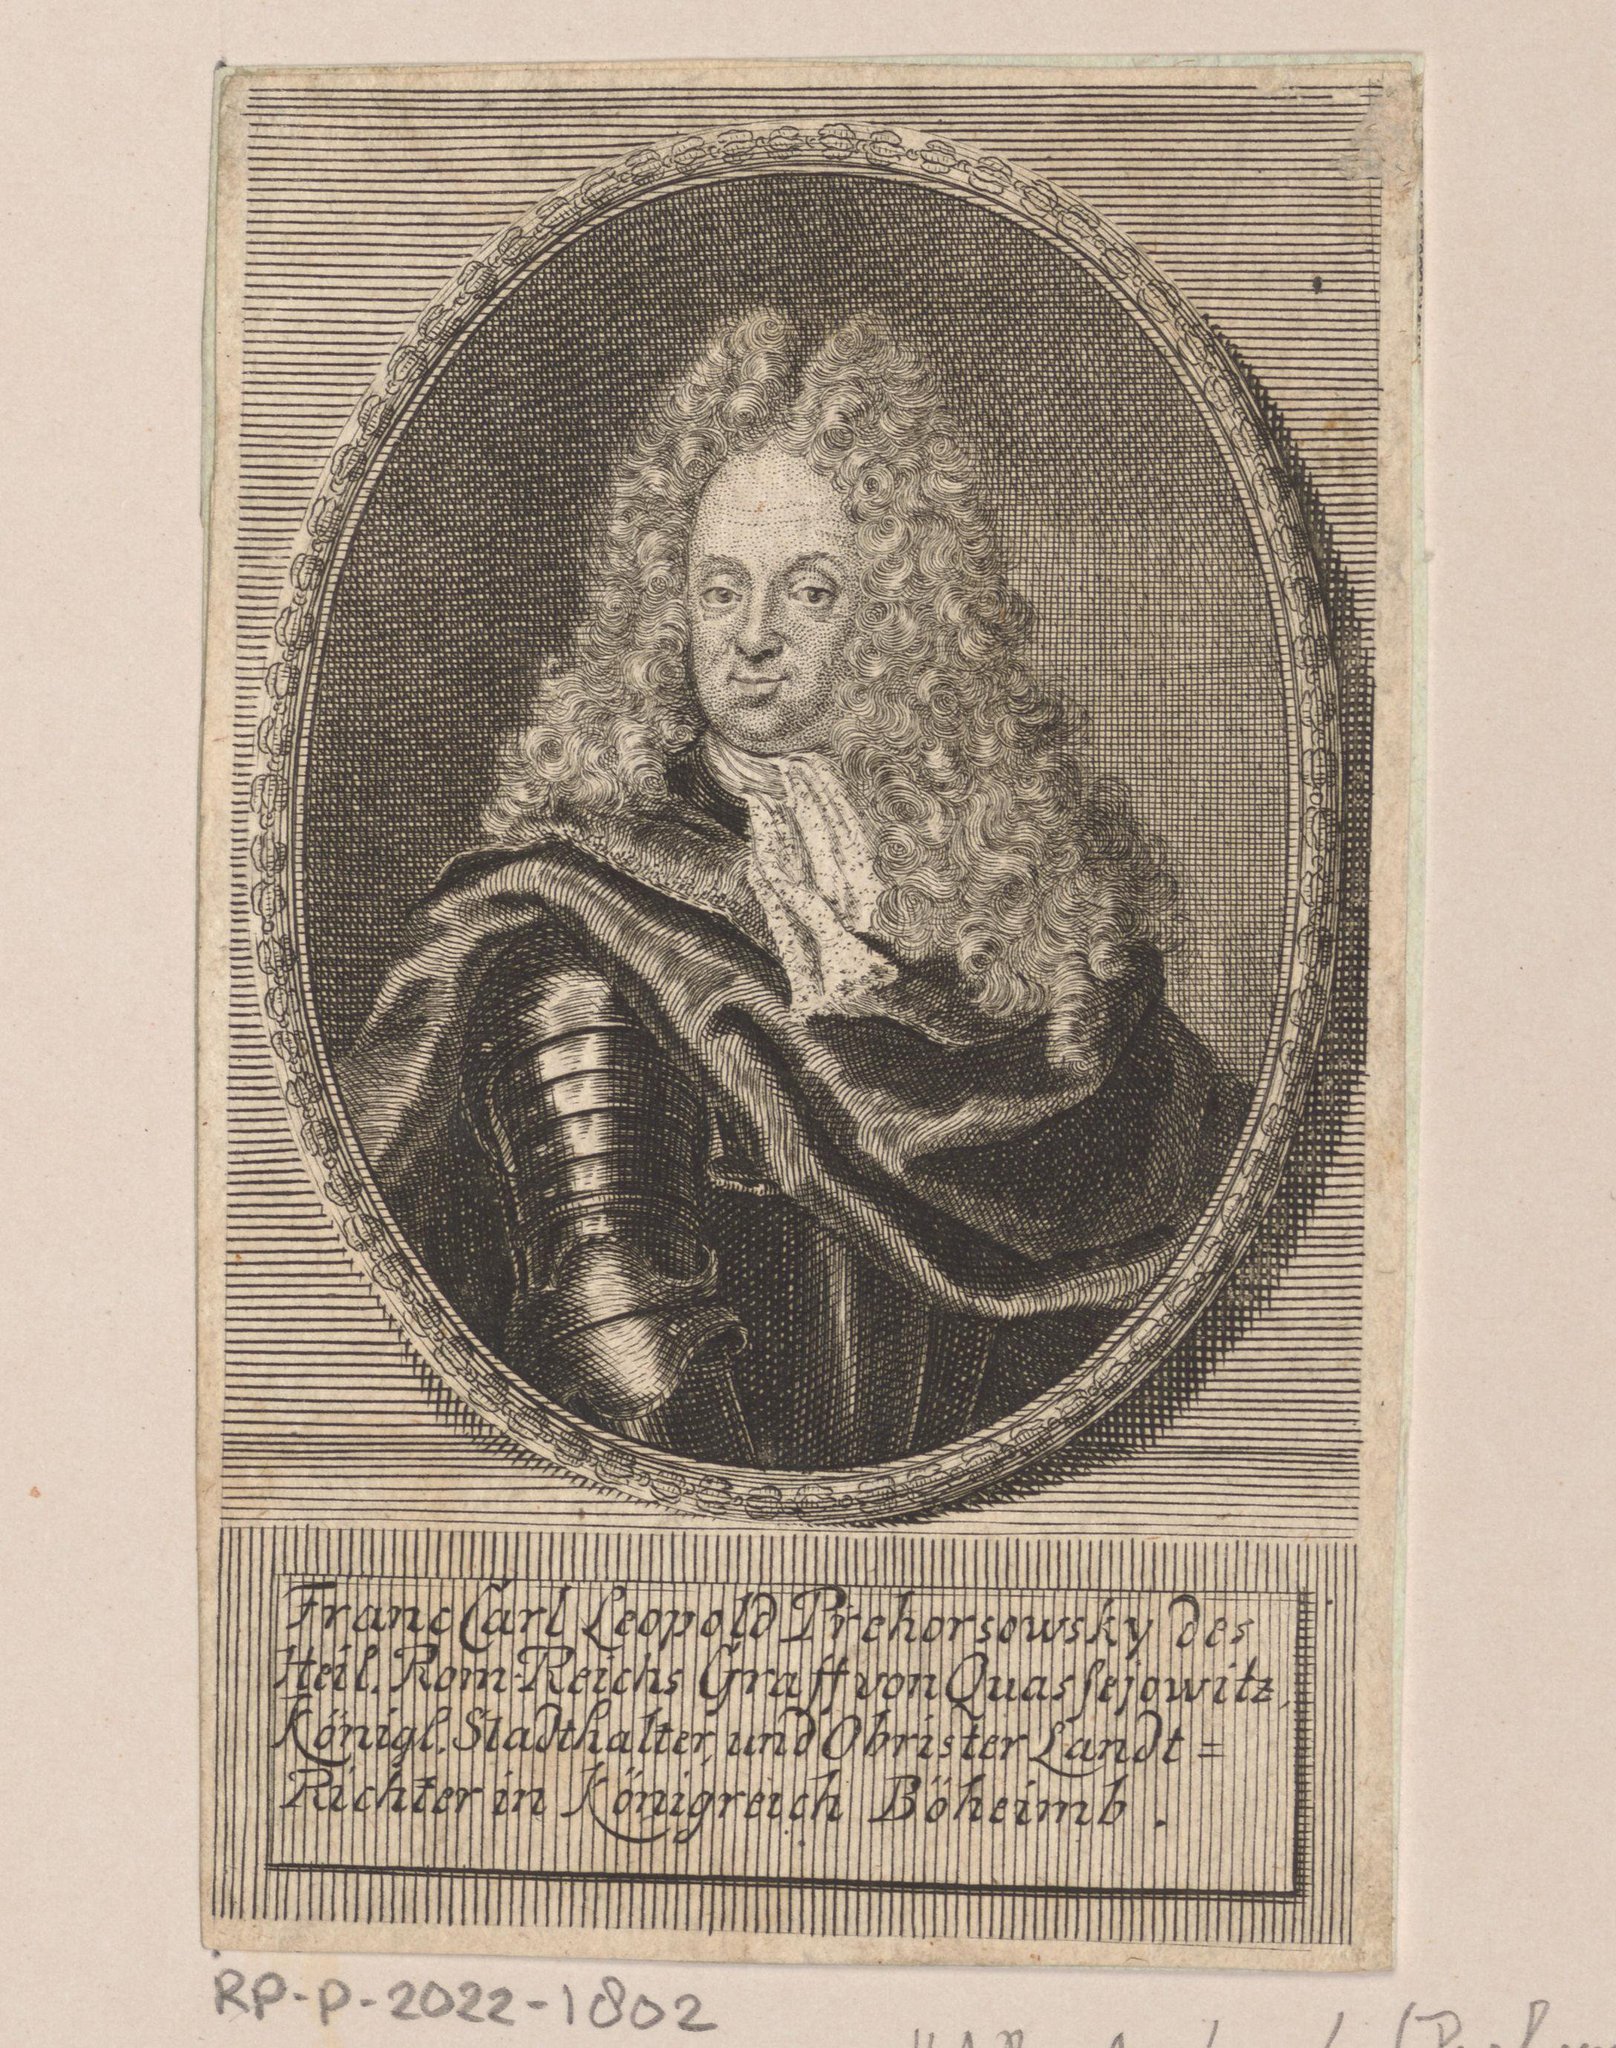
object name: print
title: Portret van Franz Carl Leopold Prehorsowsky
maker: martin bernigeroth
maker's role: print maker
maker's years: 1670-1733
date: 1680-1733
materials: paper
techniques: engraving, etching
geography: leipzig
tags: armour, historical persons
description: Met vierregelig onderschrift in het Duits.